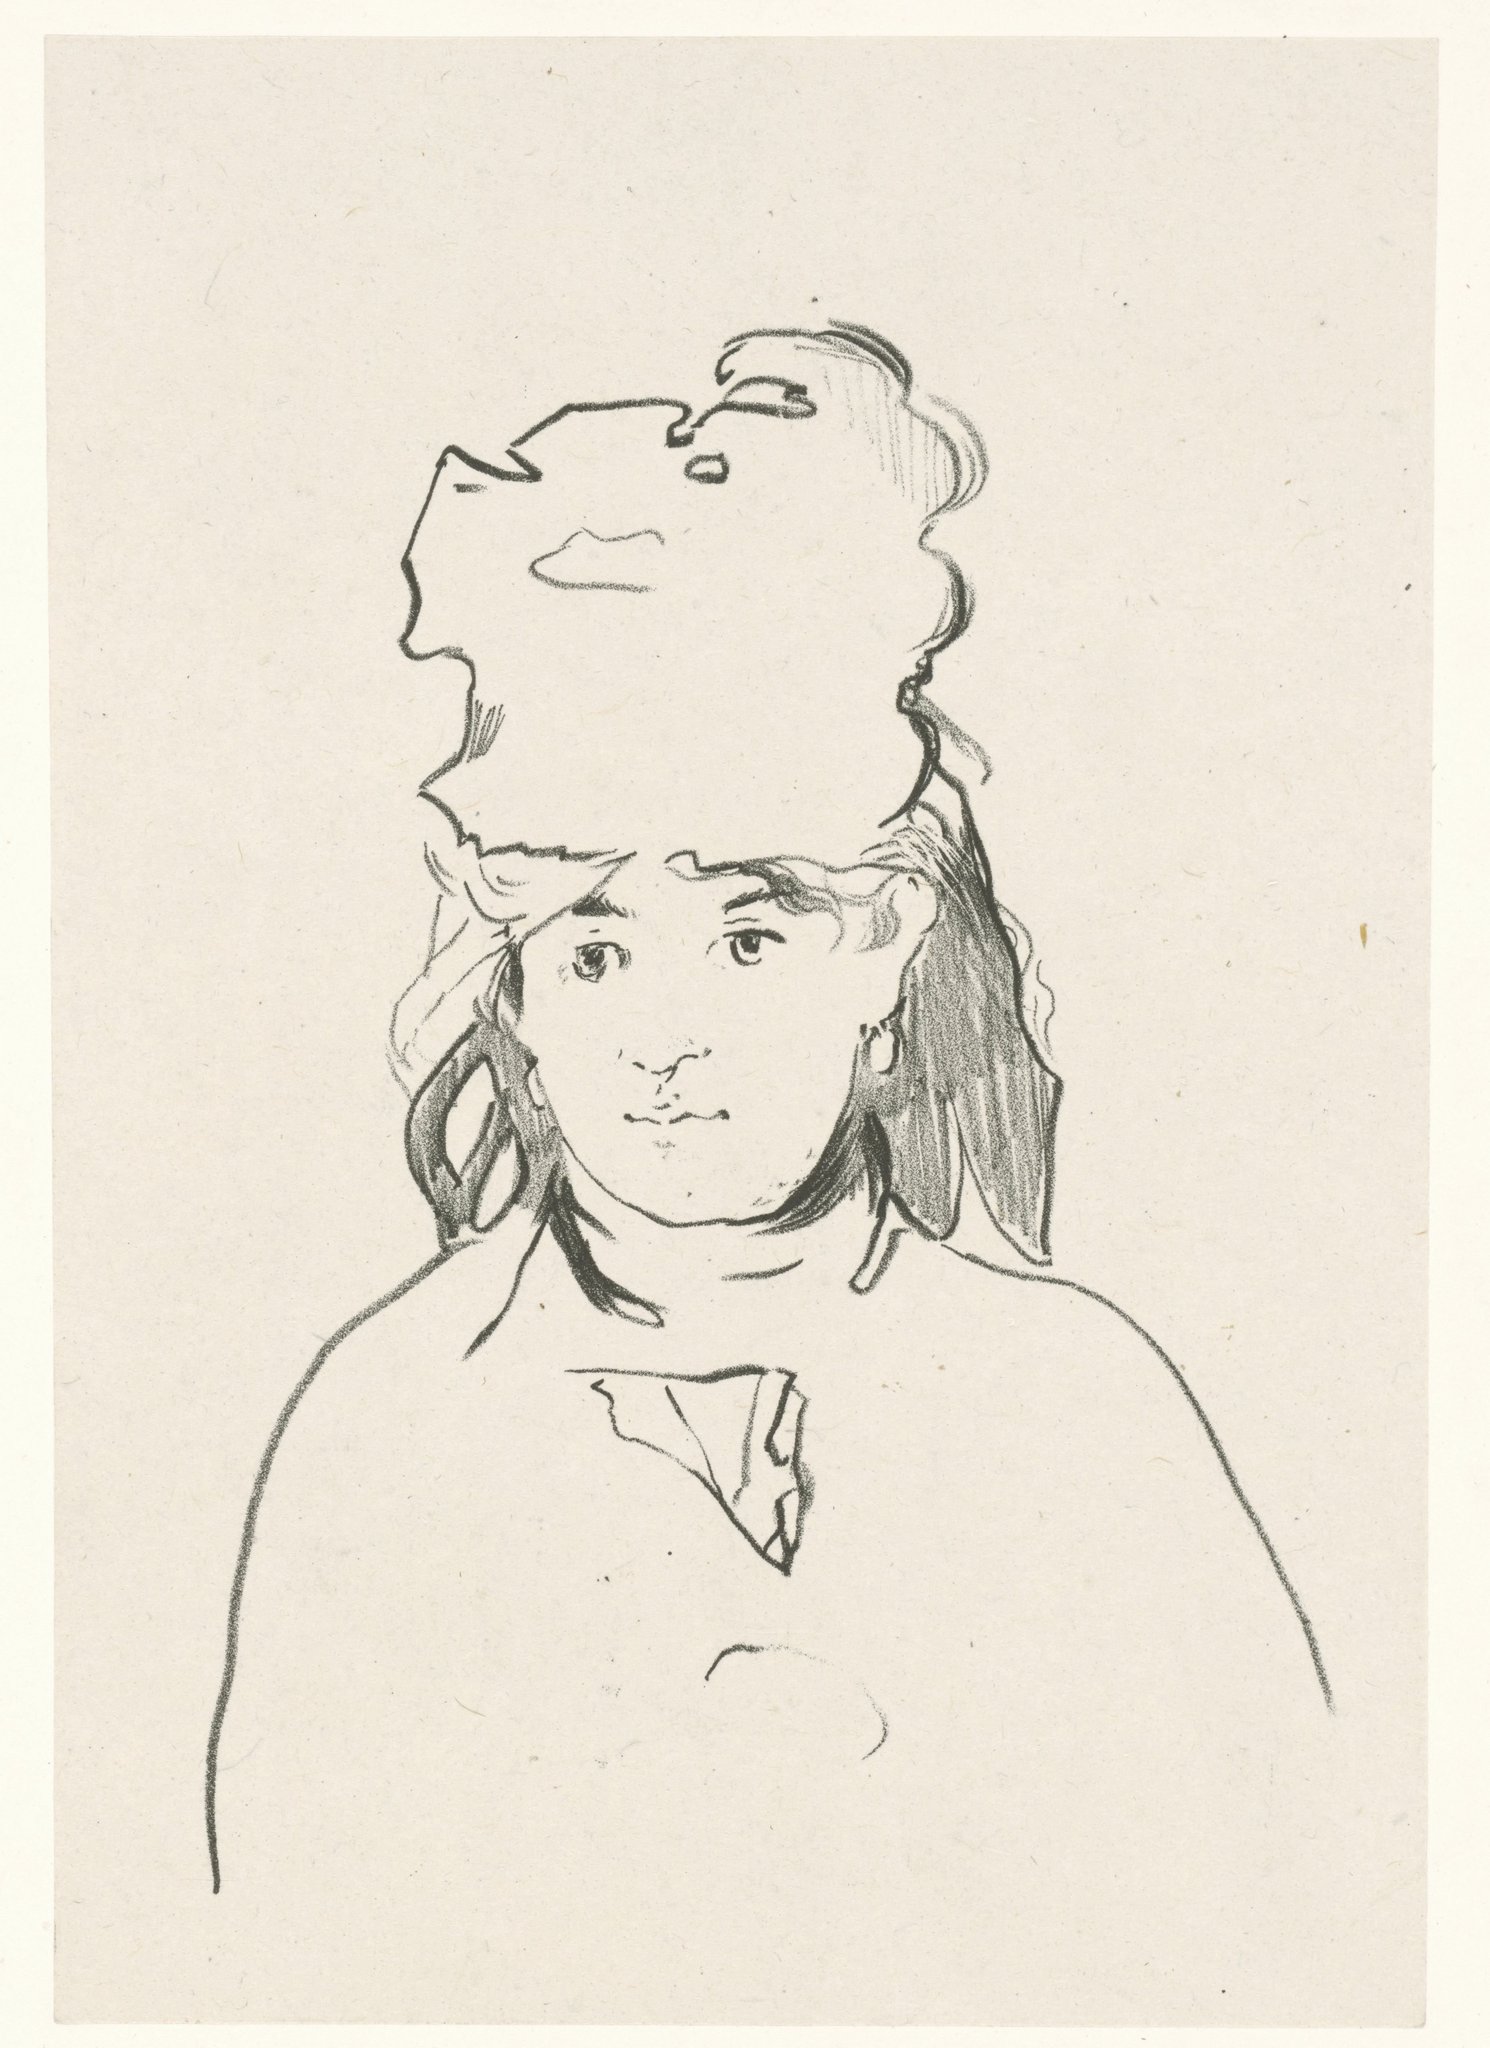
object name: print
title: Portret van kunstenares Berthe Morisot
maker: edouard manet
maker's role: painter, print maker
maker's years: 1832-1883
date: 1872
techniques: printmaking, lithograph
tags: berthe morisot, portrait, self-portrait of painter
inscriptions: collector's mark: Lugt 2760, collector's mark: Lugt 2228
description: Portret van kunstenares Berthe Morisot met hoed weergegeven in slechts een paar lijnen.